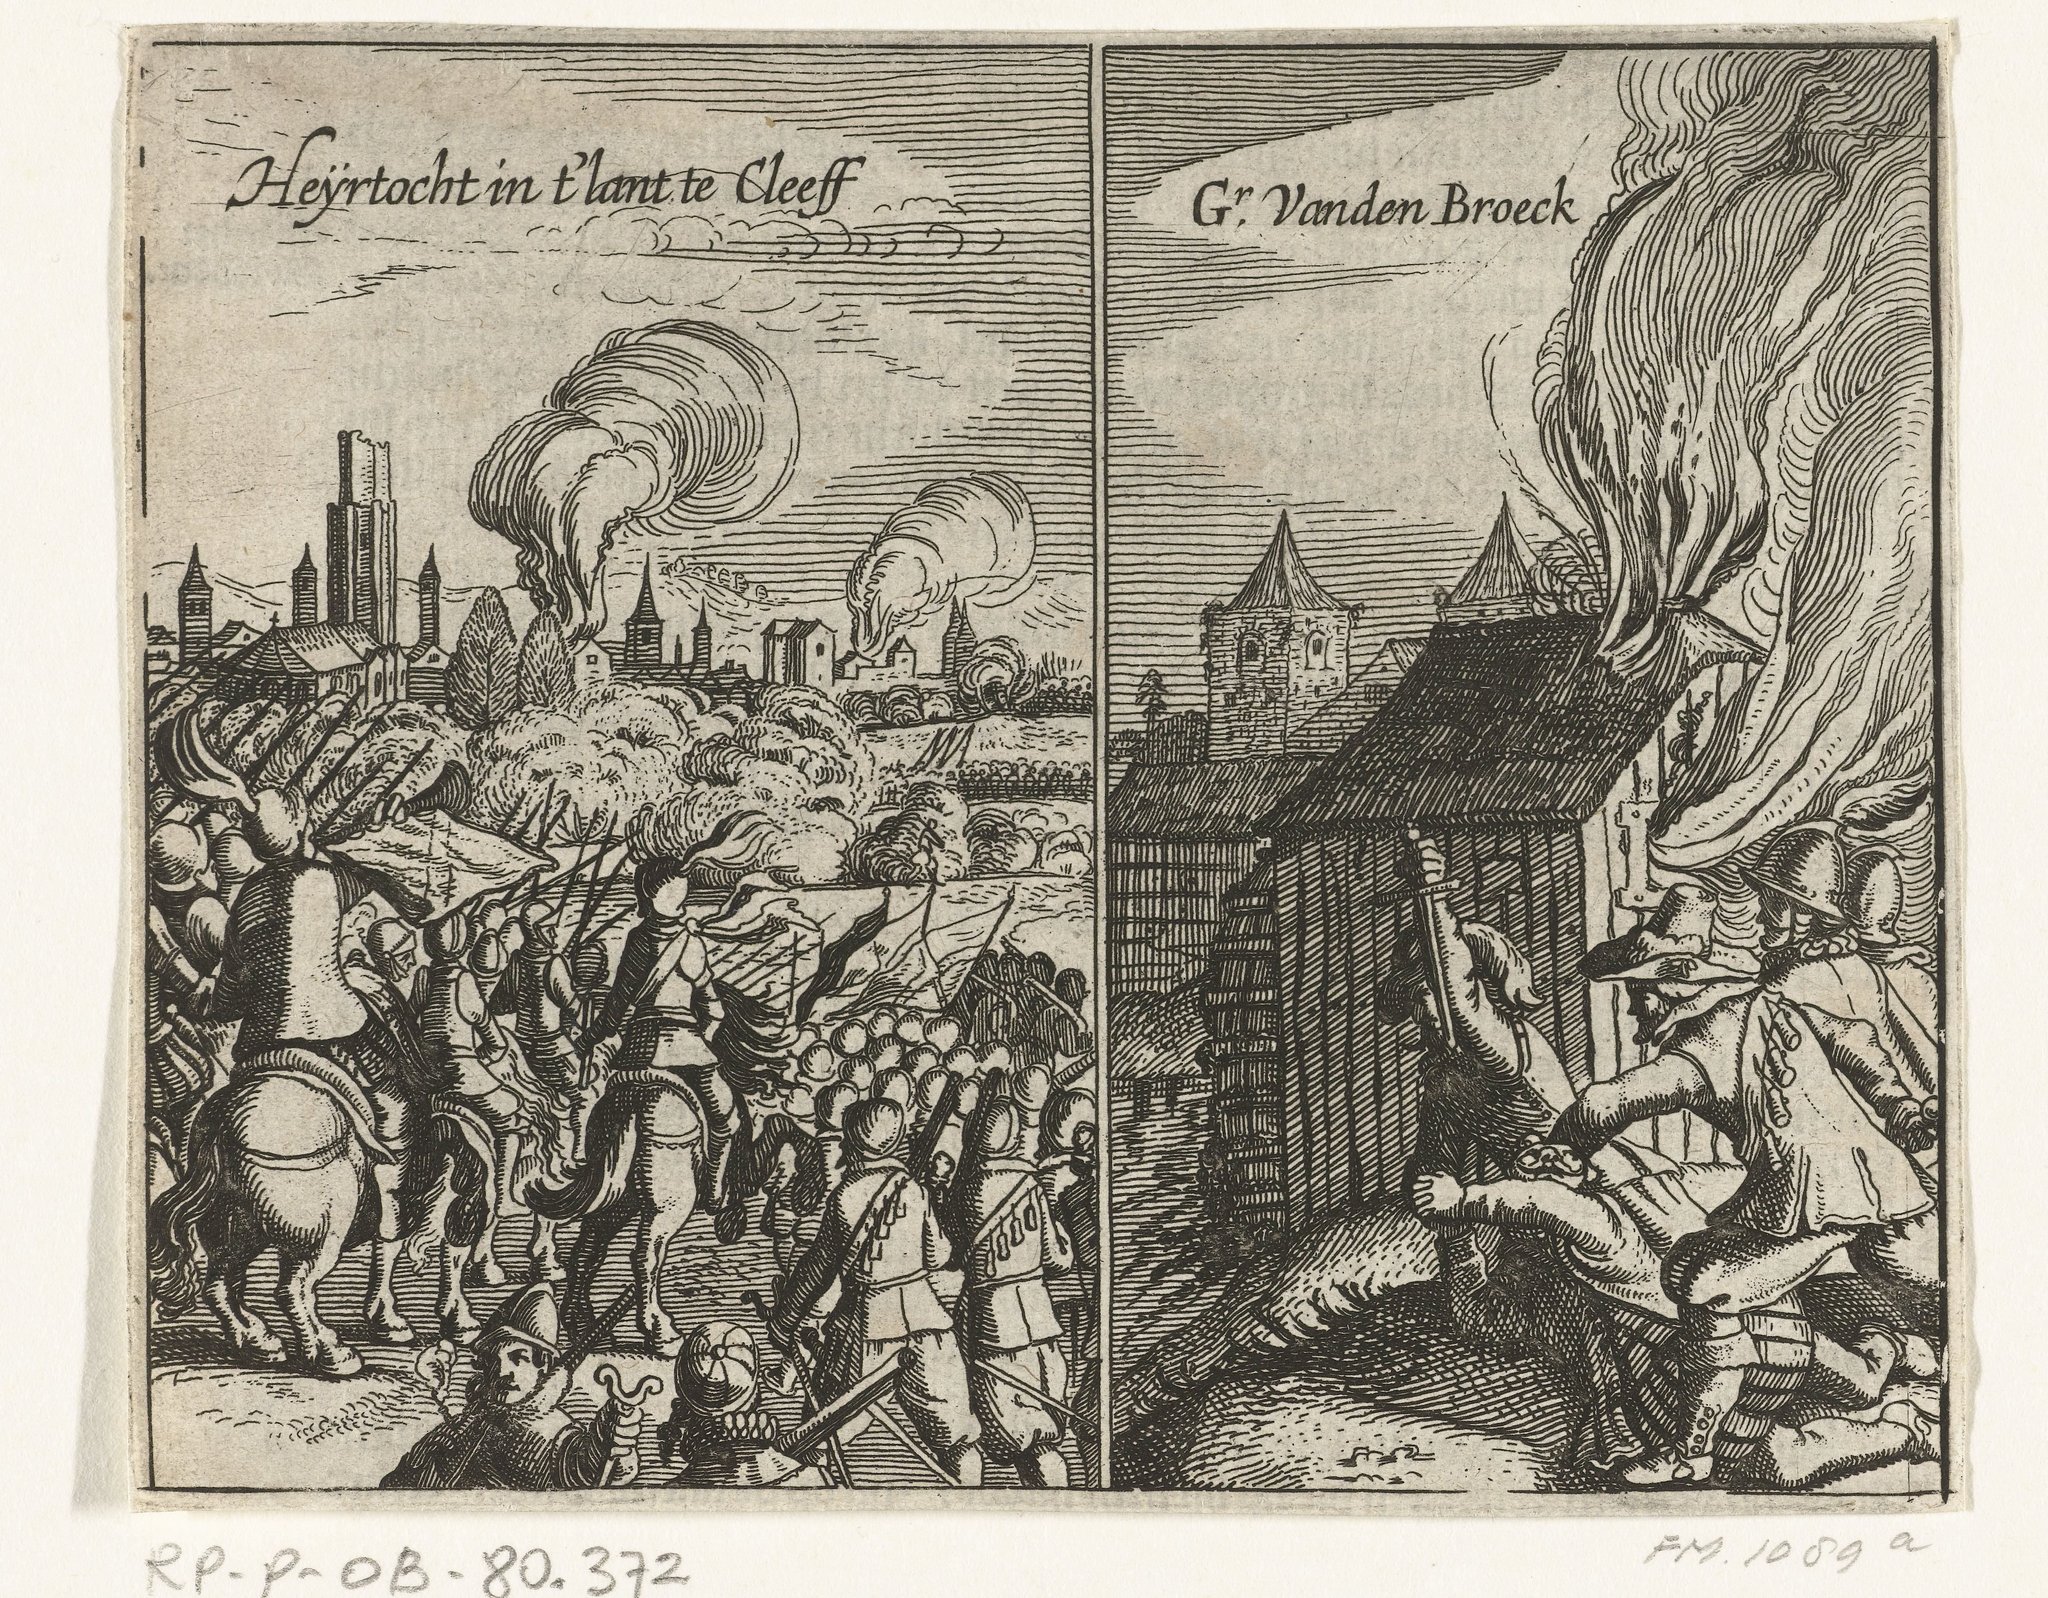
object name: history print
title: Plundertocht van de Spanjaarden in het land van Kleef en moord op Wirich von Daun, graaf van Falkenstein, 1598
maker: Anonymous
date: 1619-1621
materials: paper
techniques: etching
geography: northern netherlands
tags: plundering ~ soldiers, violent death, being killed; being mishandled and maltreated; seeking death, cleves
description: Afkomstig uit: De spaansche tiranije gheschiet in Neder-lant waer in te sien is de onmenschelicke ende wreede handelingen der Spaengiaerden ... ooc de moort van den ... prince van Orangnien, ende grave van den Broeck, C.L. vander Plasse, Amsterdam 1621, in de collectie van de Rijksmuseum Research Library, signatuur 327 K 30, p. 96.